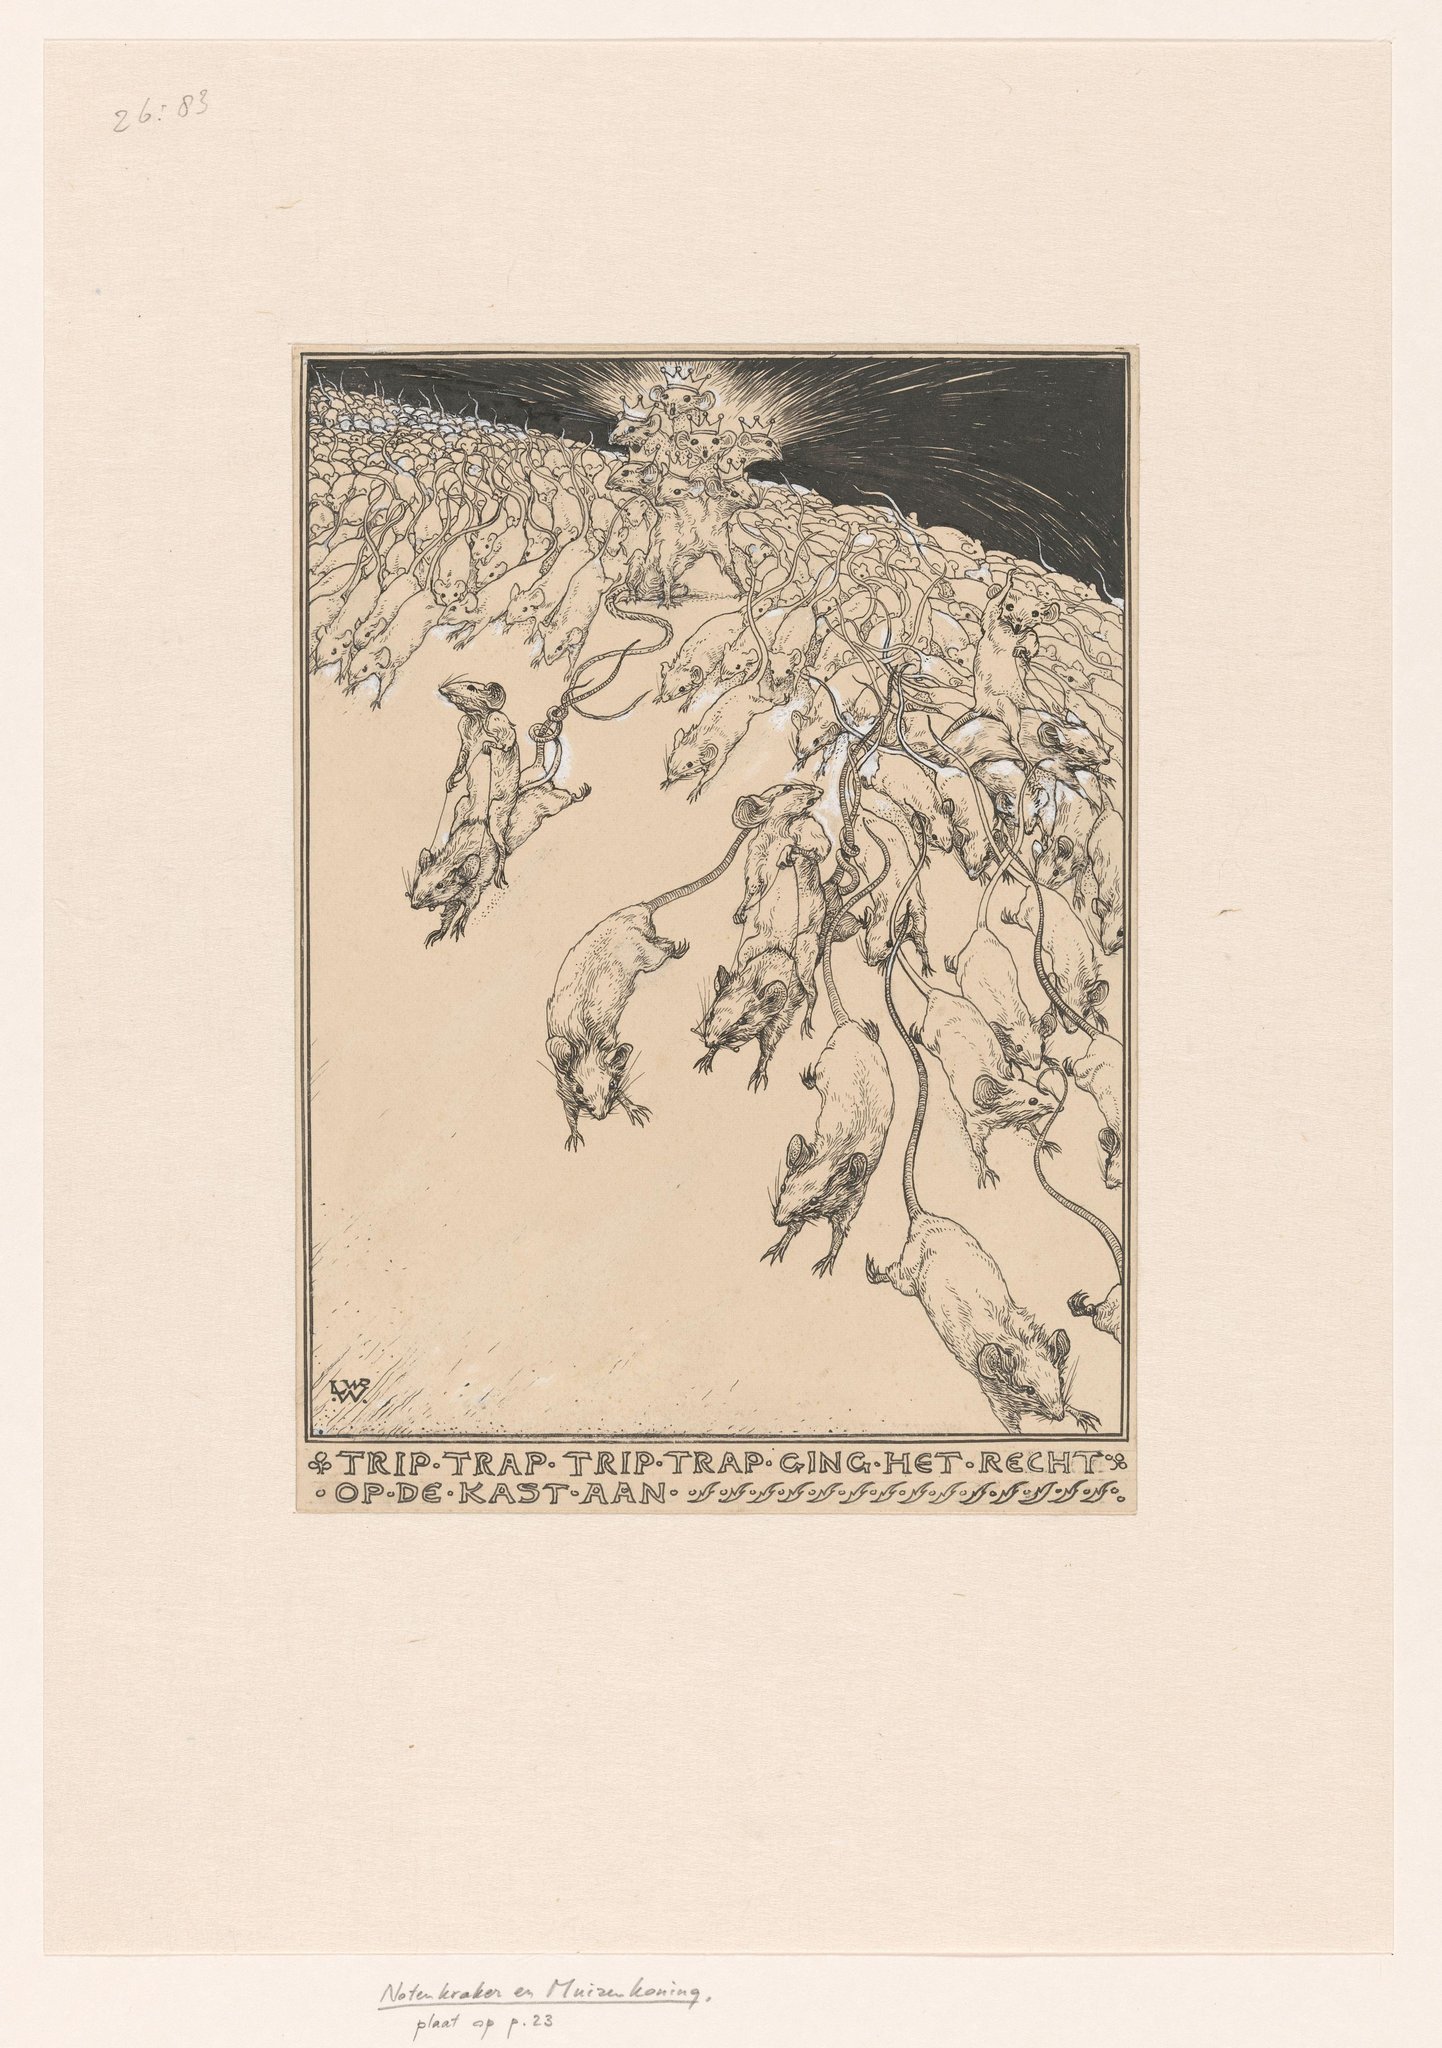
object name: drawing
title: Trip trap trip trap ging het recht op de kast aan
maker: willem wenckebach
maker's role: designer, draughtsman, painter, print maker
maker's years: 1860-1937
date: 1898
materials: paint, ink, paper, pencil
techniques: brush, pen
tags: crown (symbol of sovereignty), rodents: mouse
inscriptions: inscription: ‘Notenkraker en/ Muizen Koning/ no. 168’, collector's mark: Lugt 2228a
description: Drommen muizen rennen voorwaarts, sommige muizen rijden op de rug van een andere muis. Tussen de groep staat de Muizenkoning met zijn zeven gekroonde koppen.